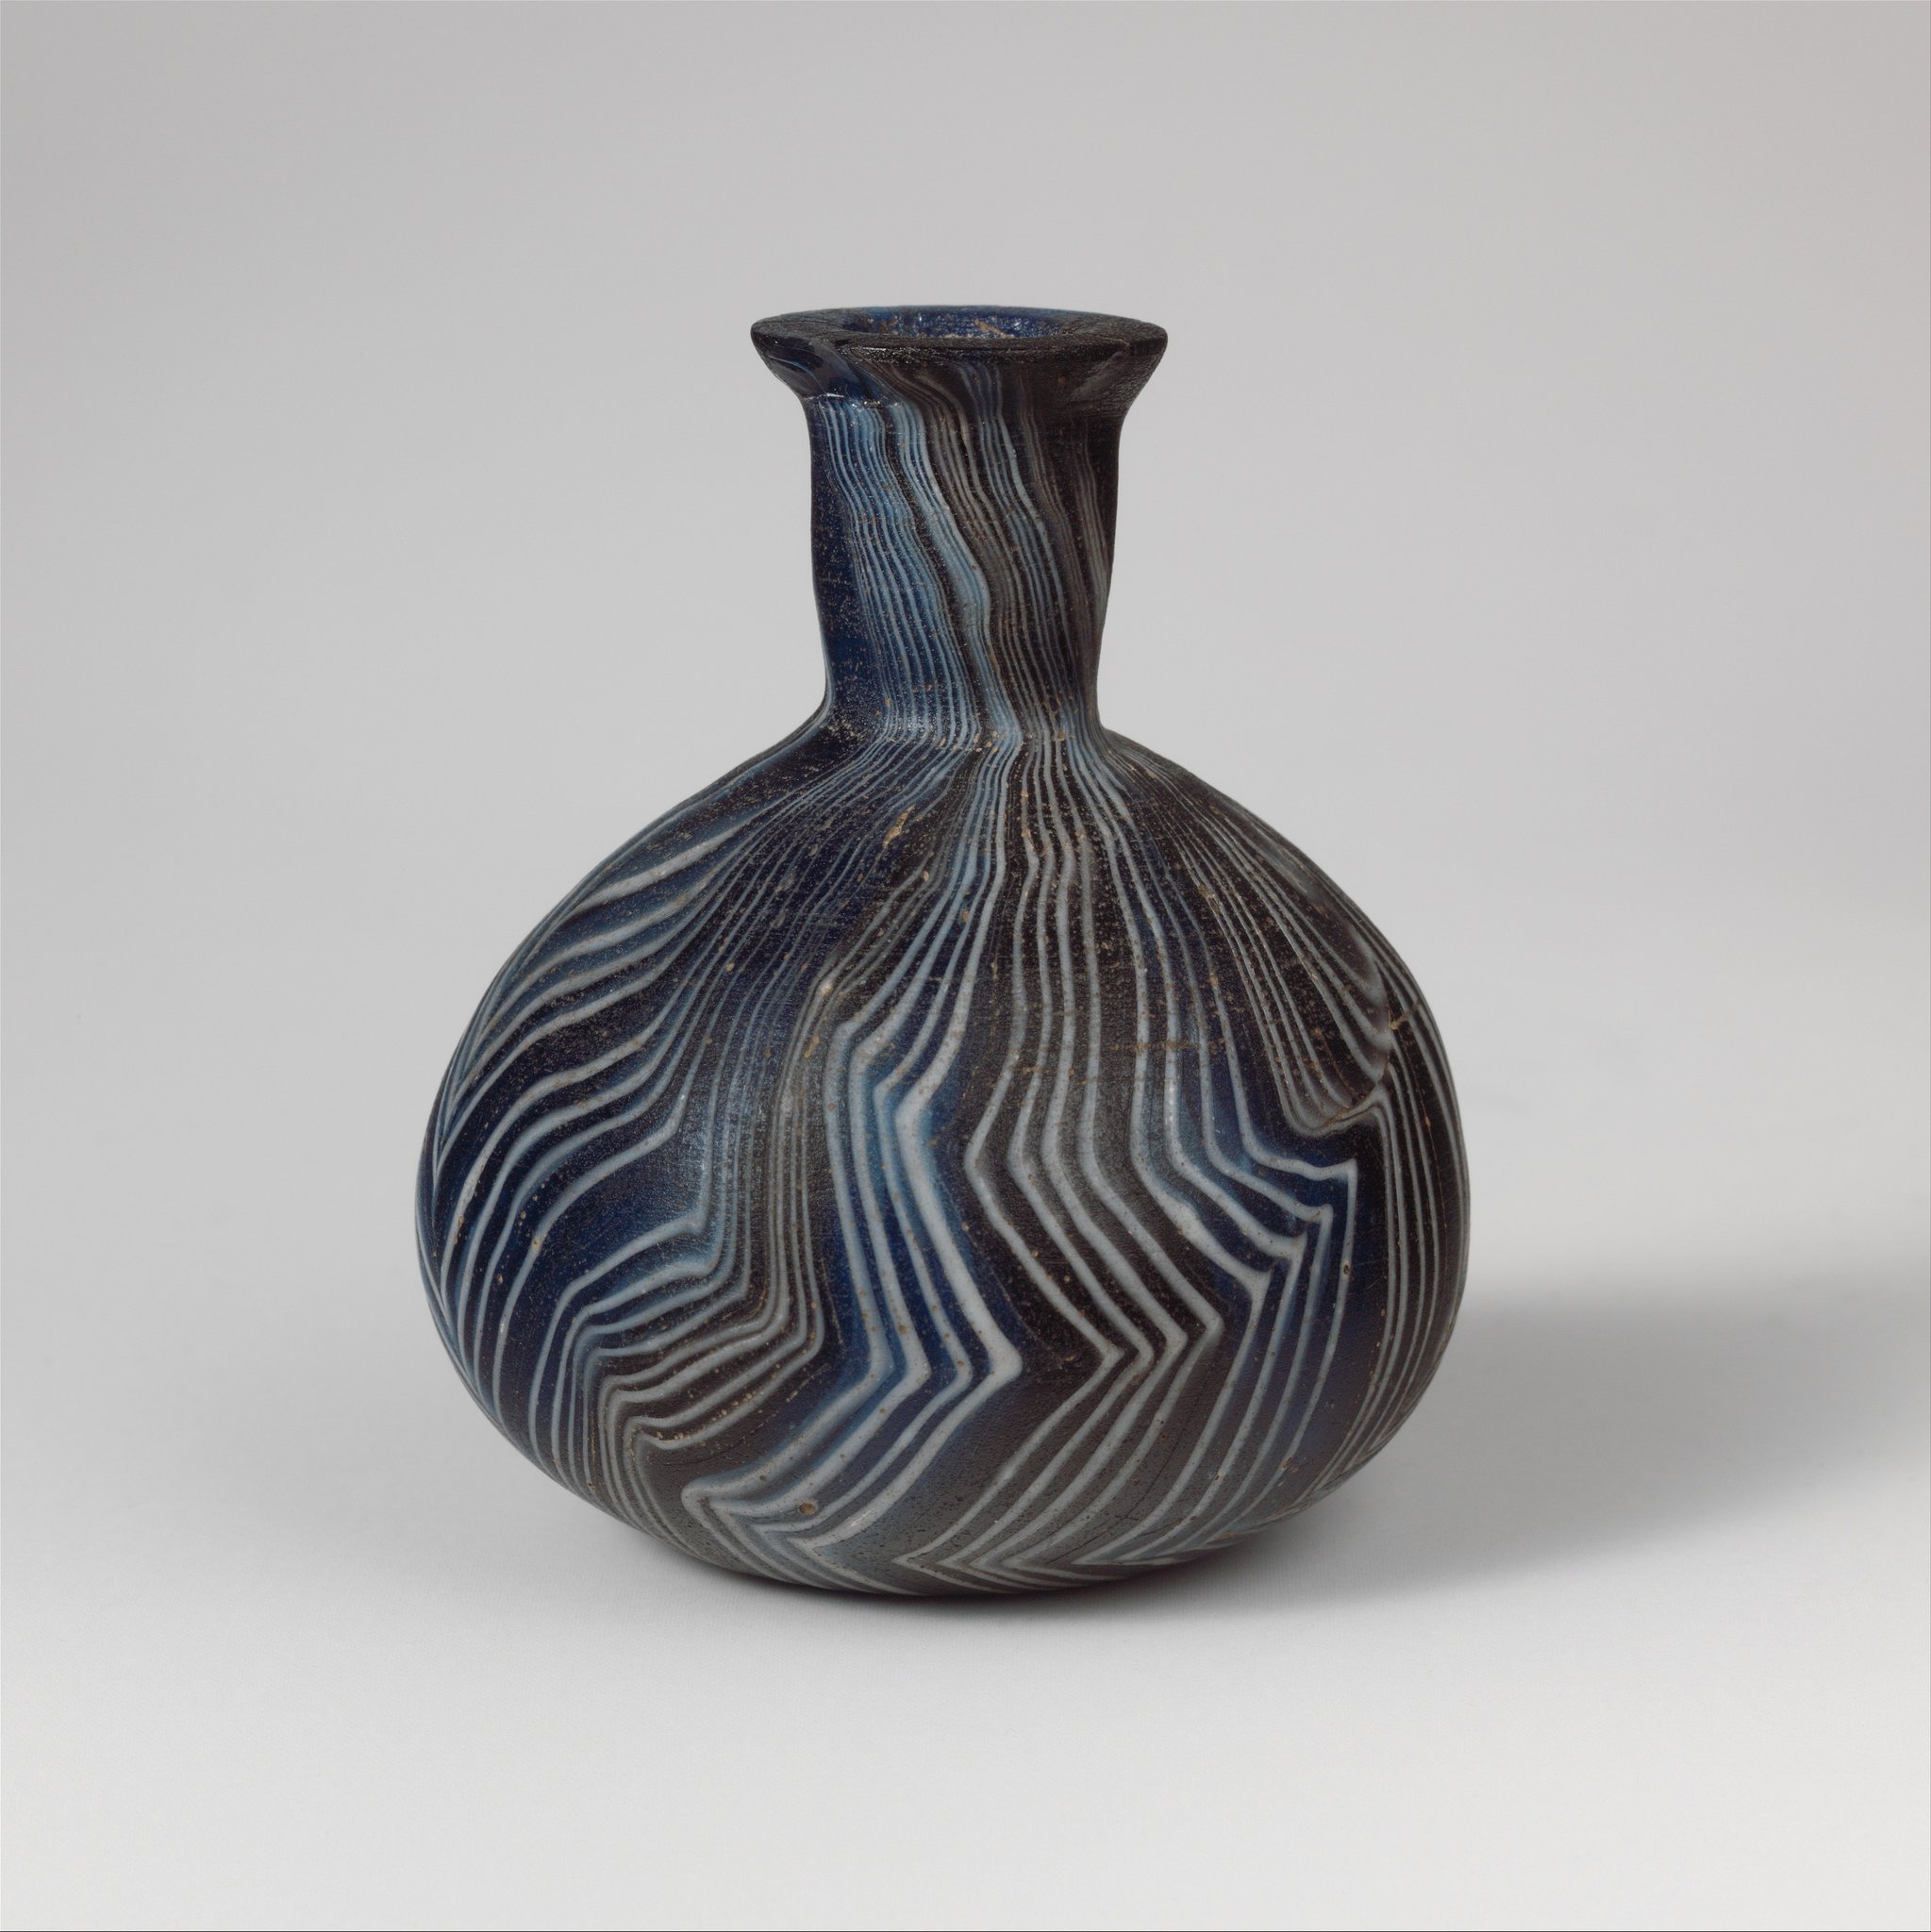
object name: bottle, mosaic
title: Glass mosaic bottle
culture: roman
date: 1-50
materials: glass